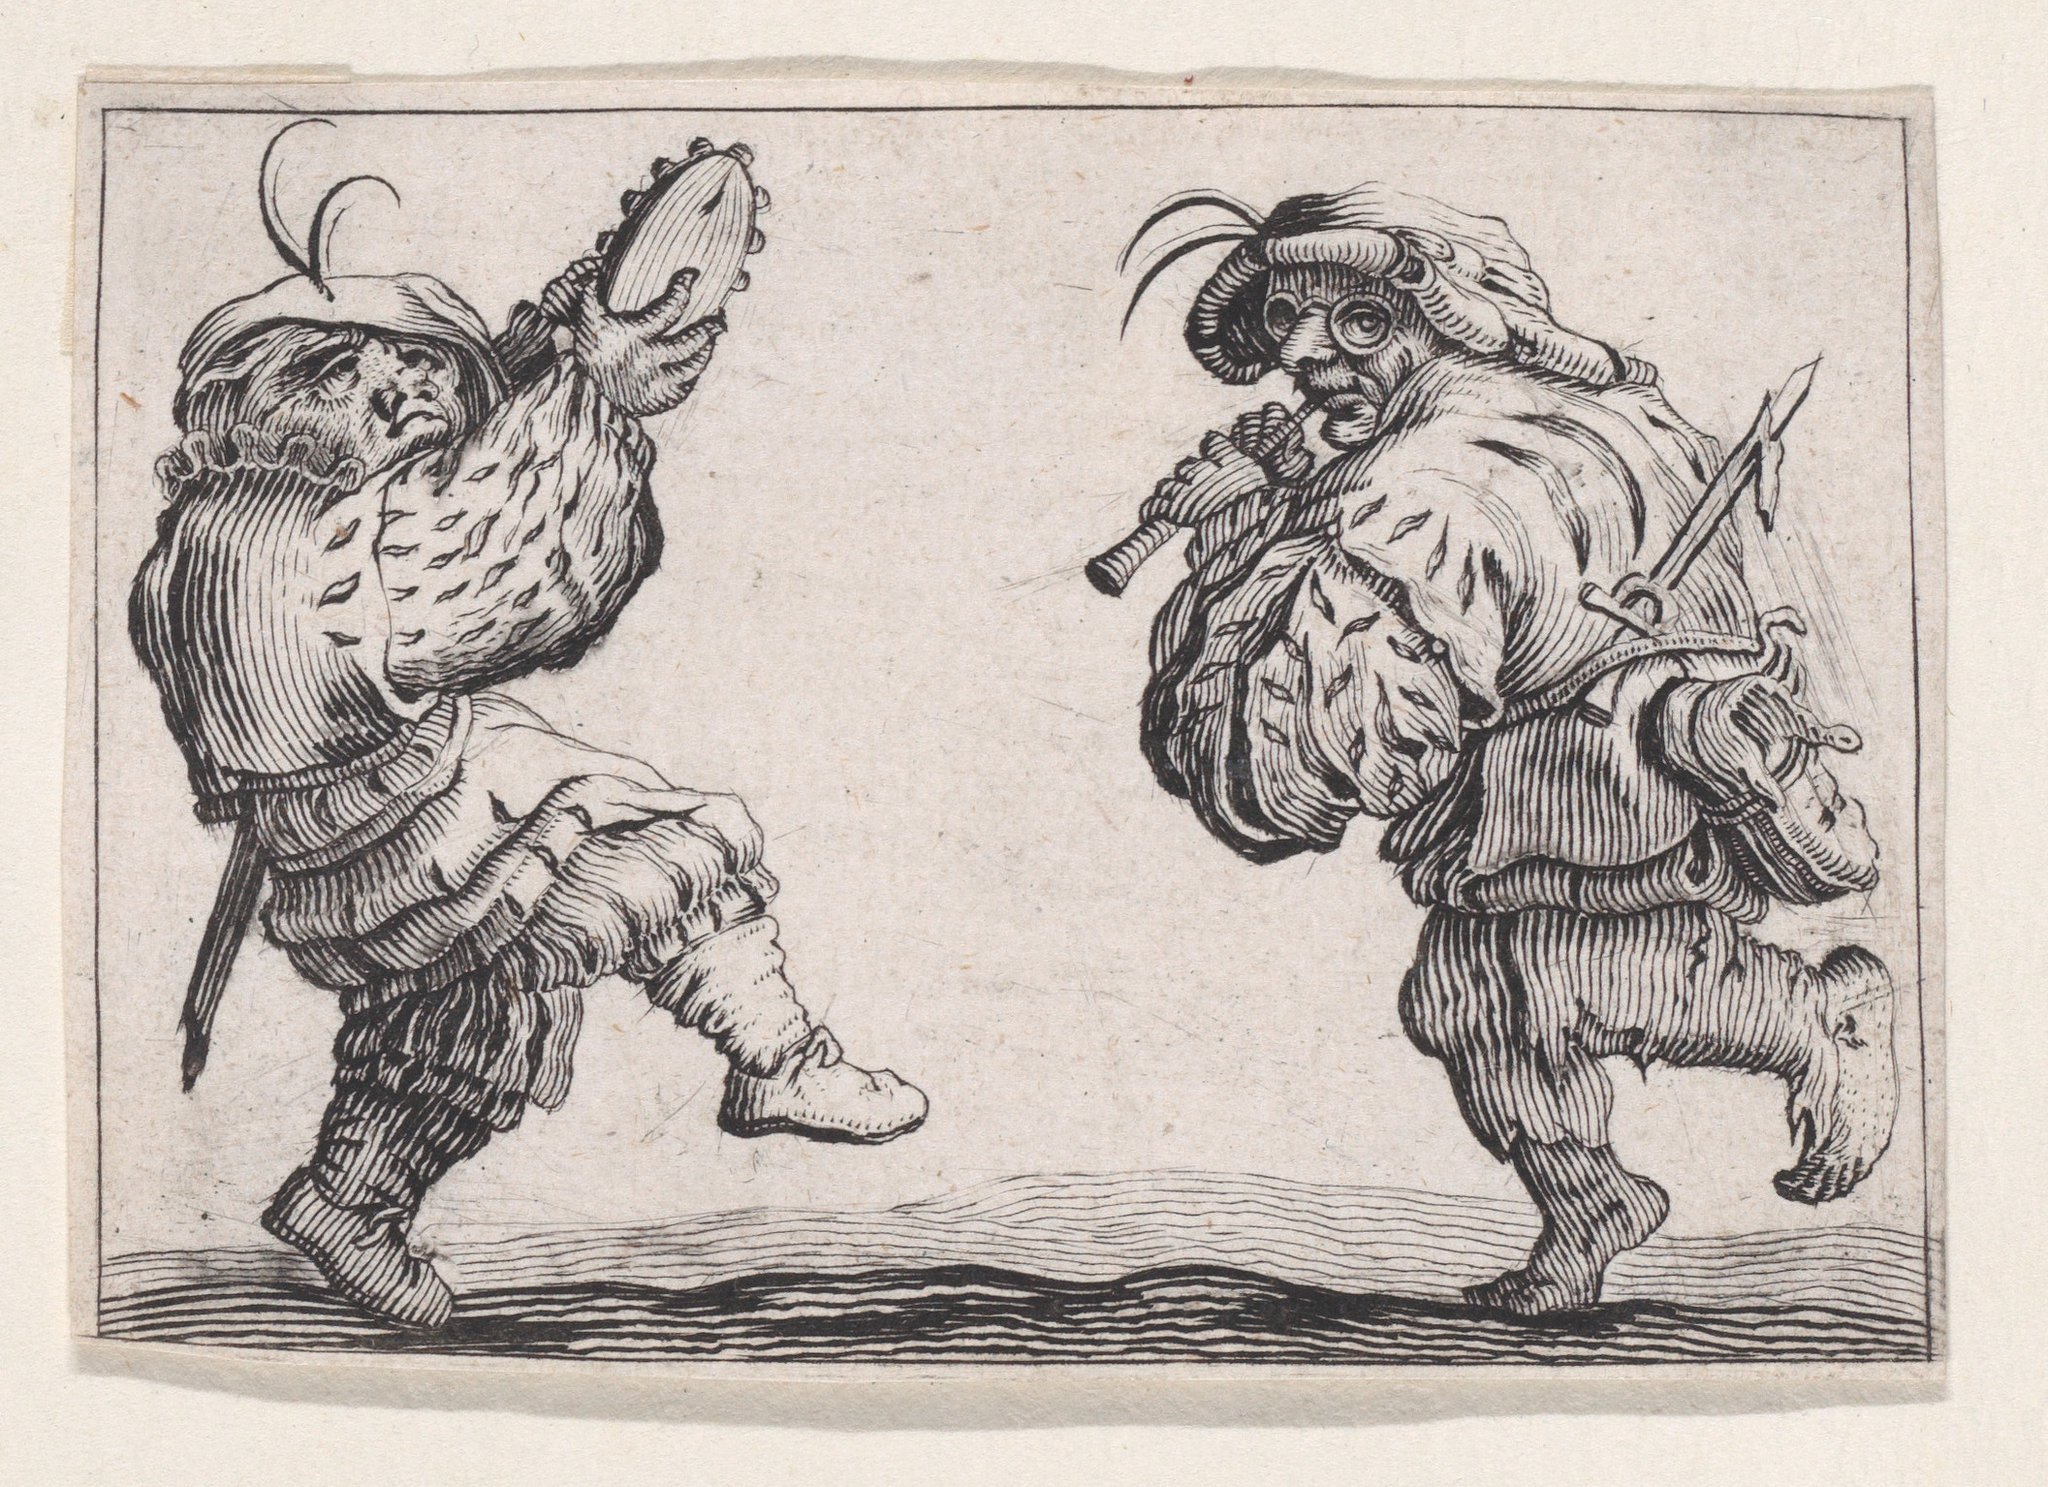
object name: print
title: Copy of Les Danseurs a la Flute et au Tambourin (Dancers with the Flute and the Tambourine), from "Les Caprices"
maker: Anonymous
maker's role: artist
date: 1601-1700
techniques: etching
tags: men,dancing